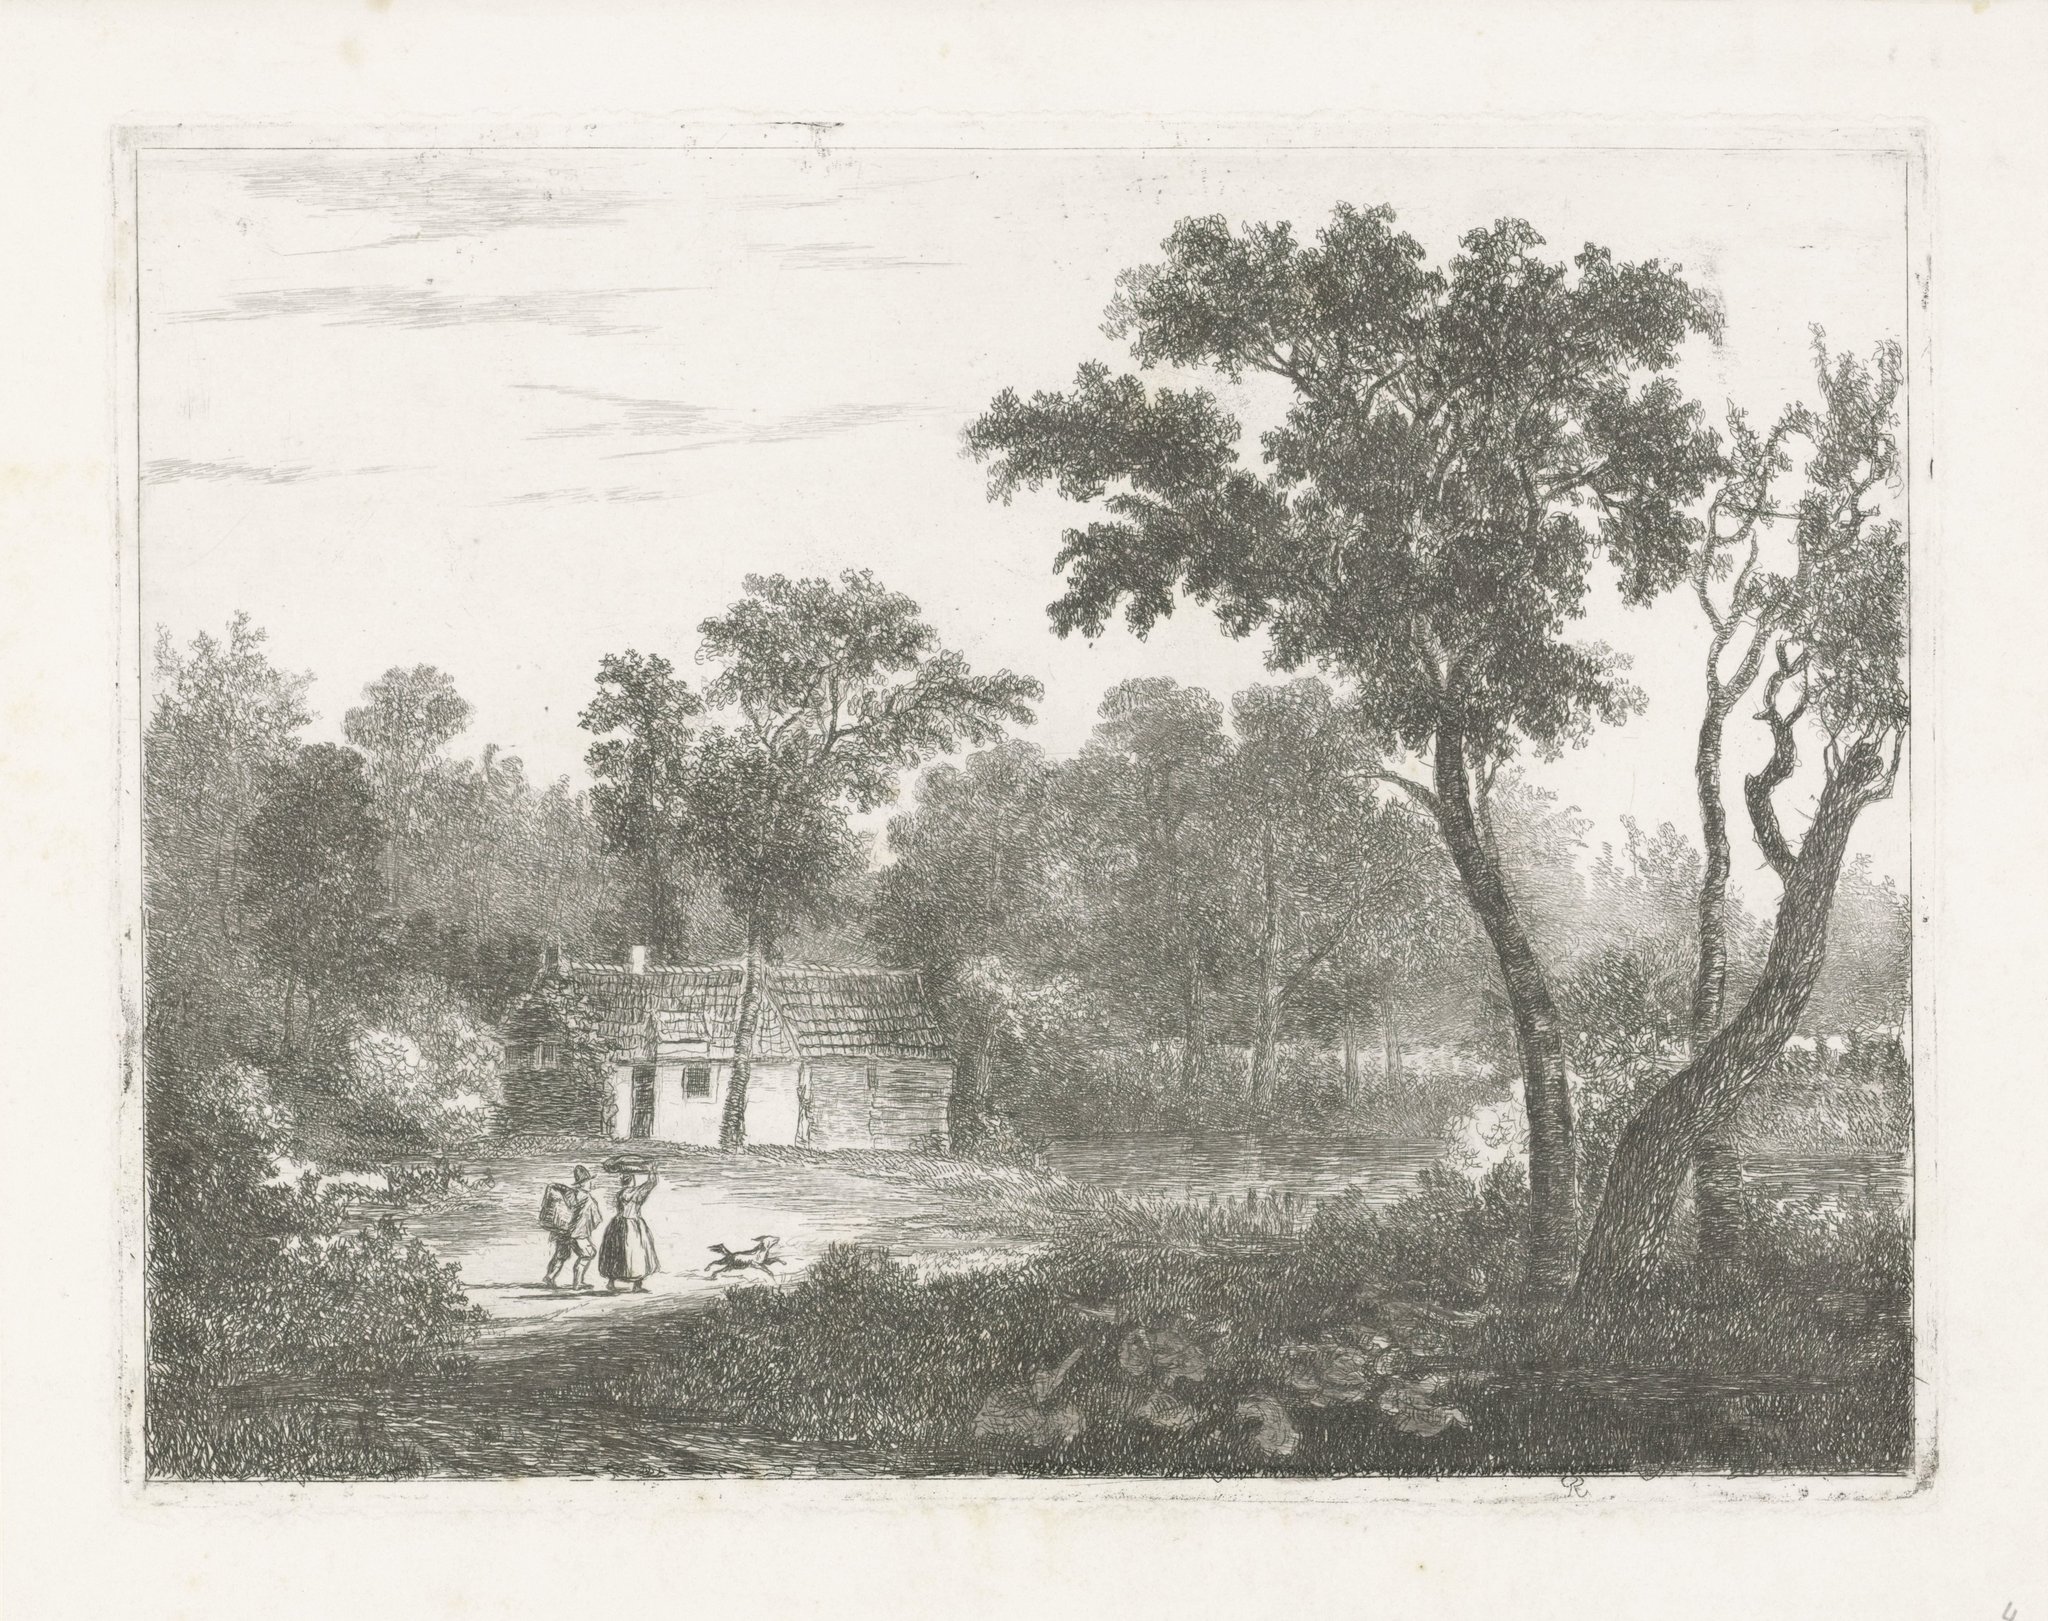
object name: print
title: Man en vrouw bij een huis aan het water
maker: hermanus jan hendrik van rijkelijkhuysen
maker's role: painter, print maker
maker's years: 1813-1883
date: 1823-1883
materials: paper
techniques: drypoint, etching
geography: utrecht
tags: rural housing, e.g. country-house, villa, cottage (+ variant), lake, forest, wood, glade, 'lichtung im wald', dog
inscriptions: collector's mark: Lugt 2228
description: Gezicht op een open plek in het bos met een meer waar een huis naast ligt. Op de voorgrond een man en een vrouw met een hond.